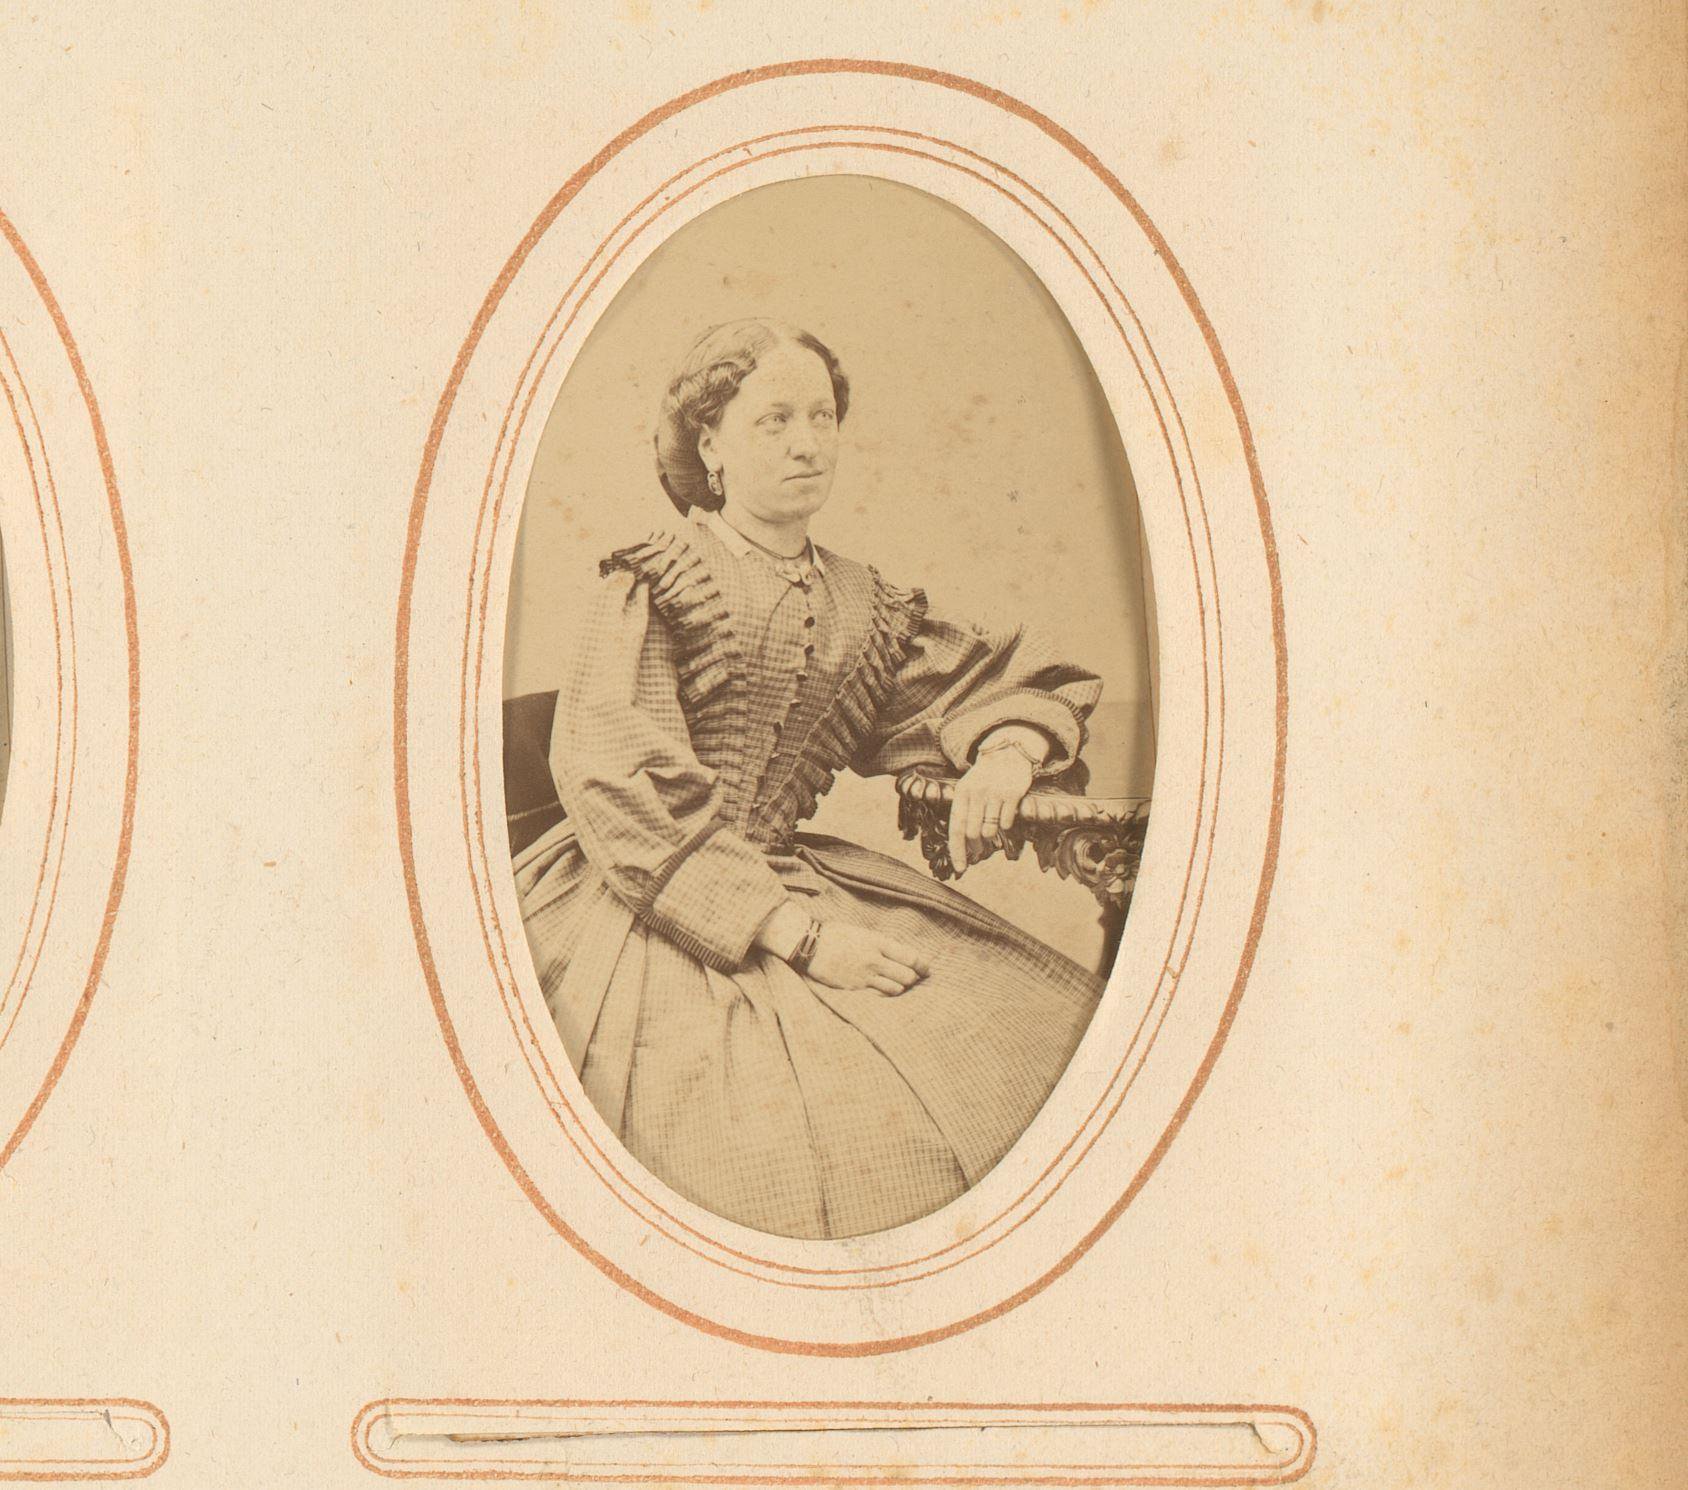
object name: photograph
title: Portret van een zittende vrouw, mogelijk Amanda Hedberg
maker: johan isberg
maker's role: fotograaf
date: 1864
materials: cardboard, photographic support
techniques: albumen print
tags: adult woman, historical persons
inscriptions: annotation: ‘[...]anda Carolnina/ Hedberg/ [...] 20 May 1835/ 1864_/ Amanda Hederg/ & Berman/ 1835’, inscription: ‘JOh. Isberg/ Stockholm/ Lalla Nygatan No. 4/ (...)’